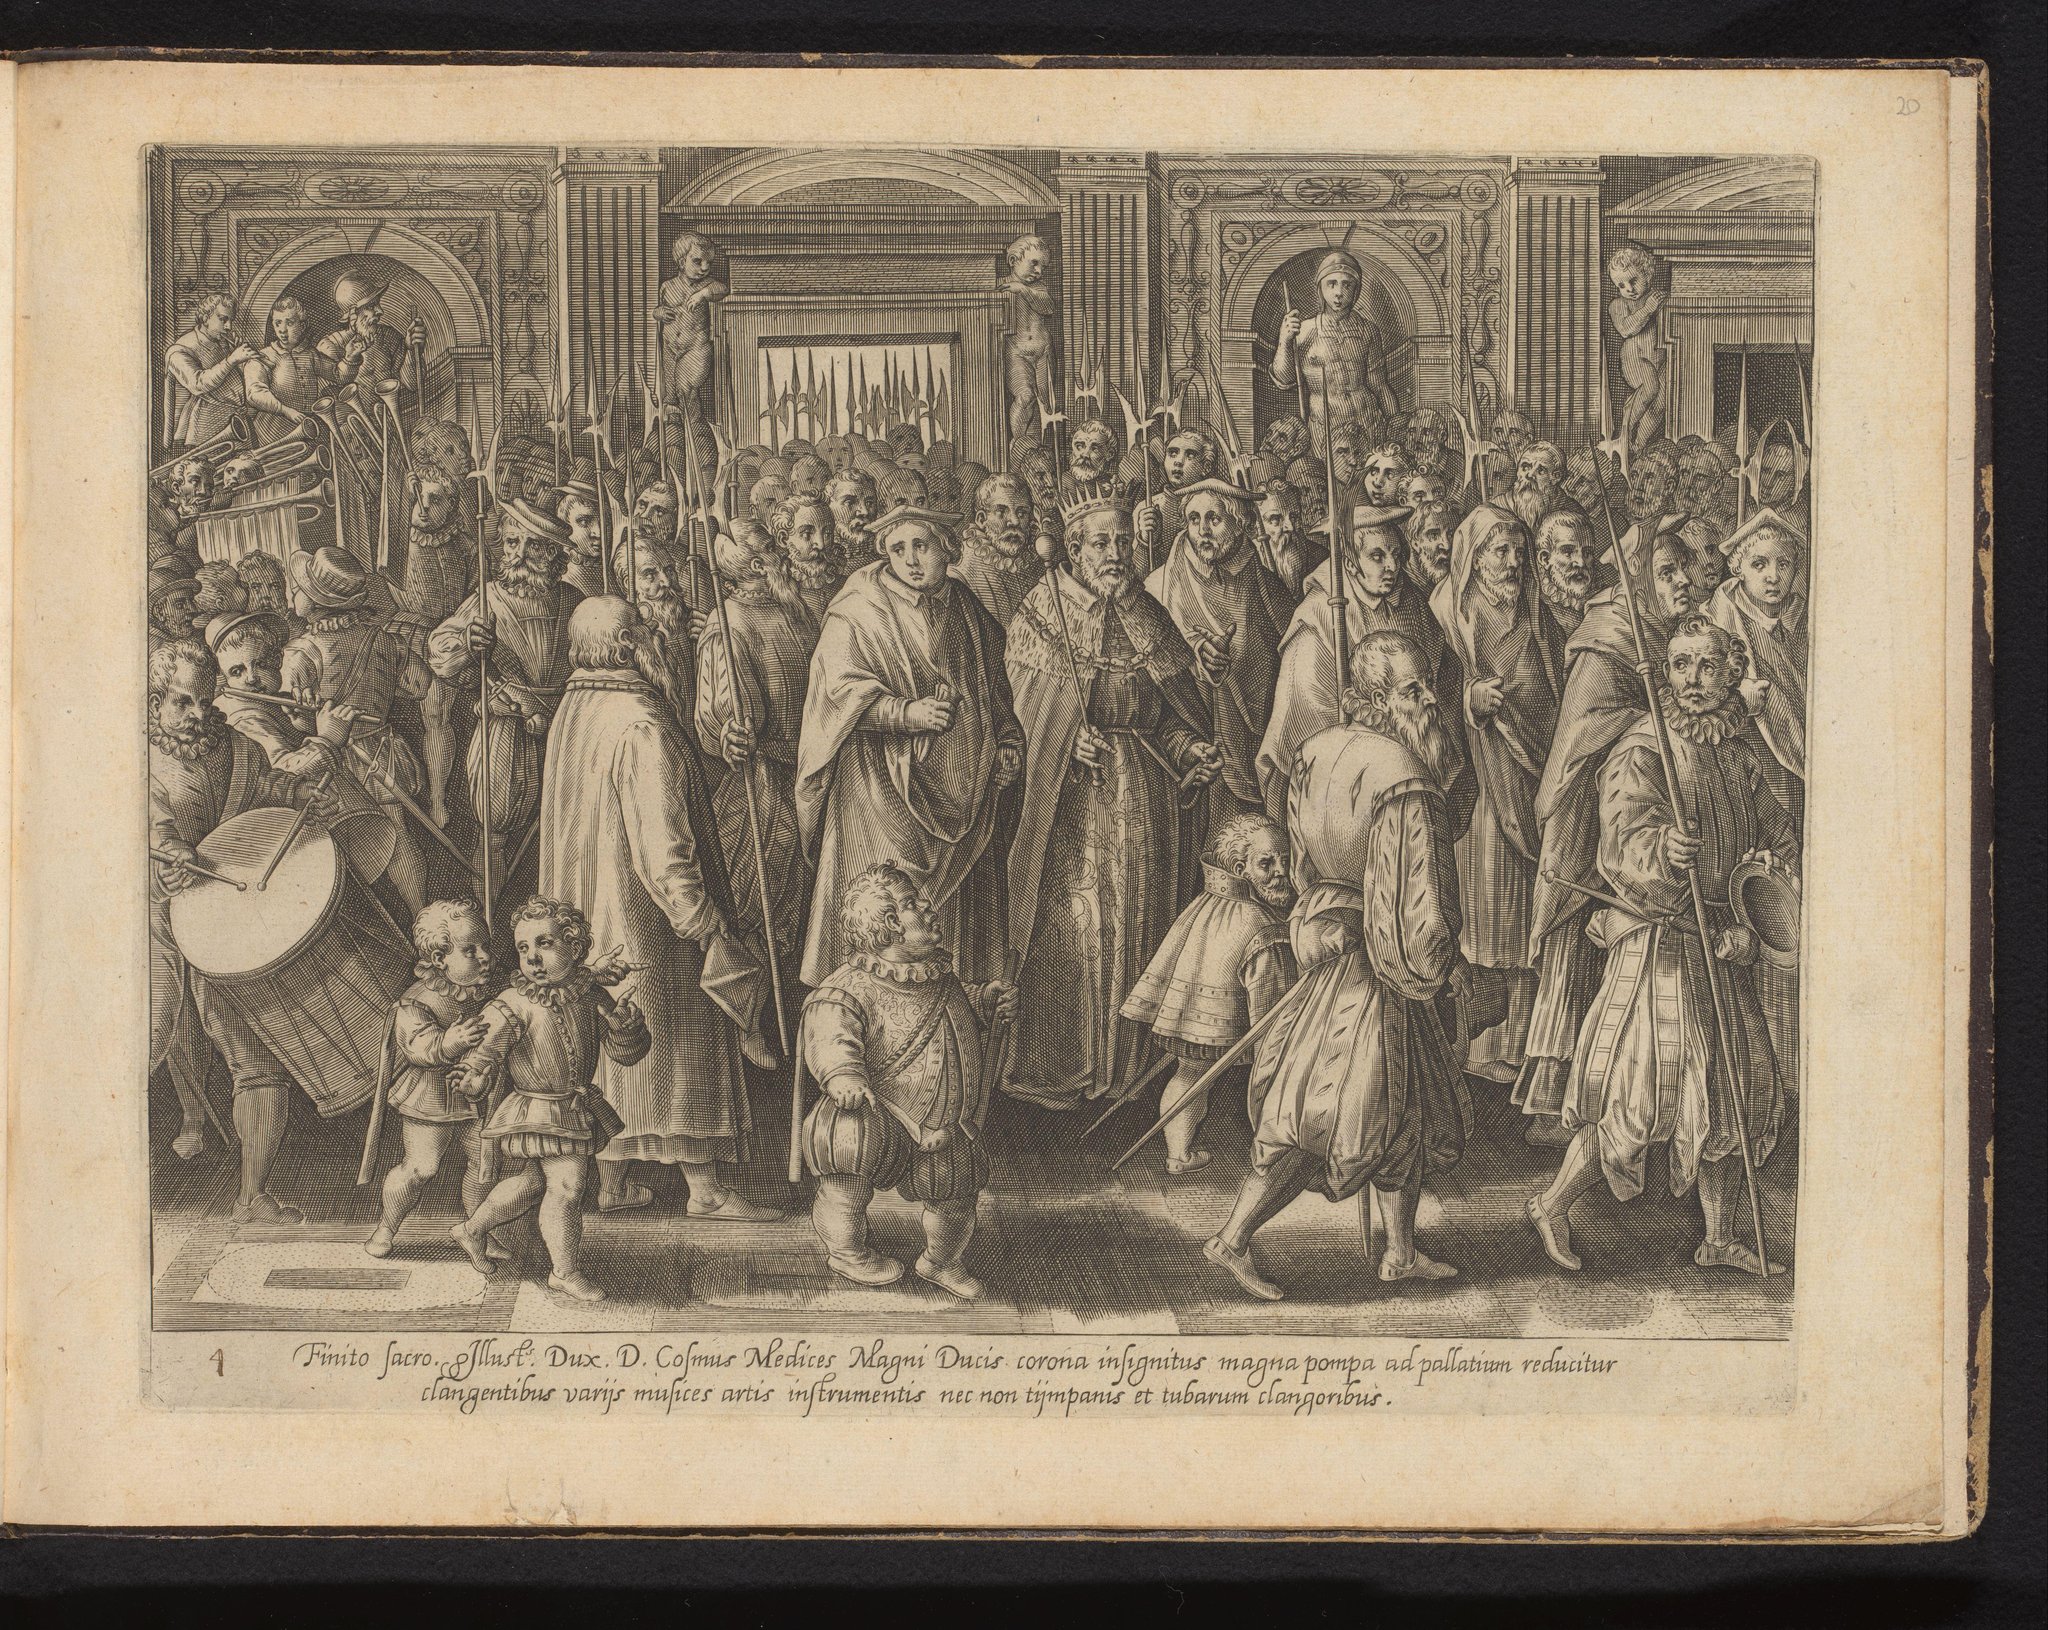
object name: history print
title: Familiegeschiedenis van het geslacht de' Medici (deel 3)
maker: philips galle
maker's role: print maker, publisher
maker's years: 1537-1612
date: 1582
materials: paper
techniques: engraving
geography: florence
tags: cosimo i de' medici, rome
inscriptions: inscription: ‘4’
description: Na zijn kroning keert groothertog Cosimo I de' Medici in optocht terug naar zijn paleis. In de ondermarge twee regels tekst in het Latijn. Met pen genummerd 4. De prent maakt deel uit van een album.